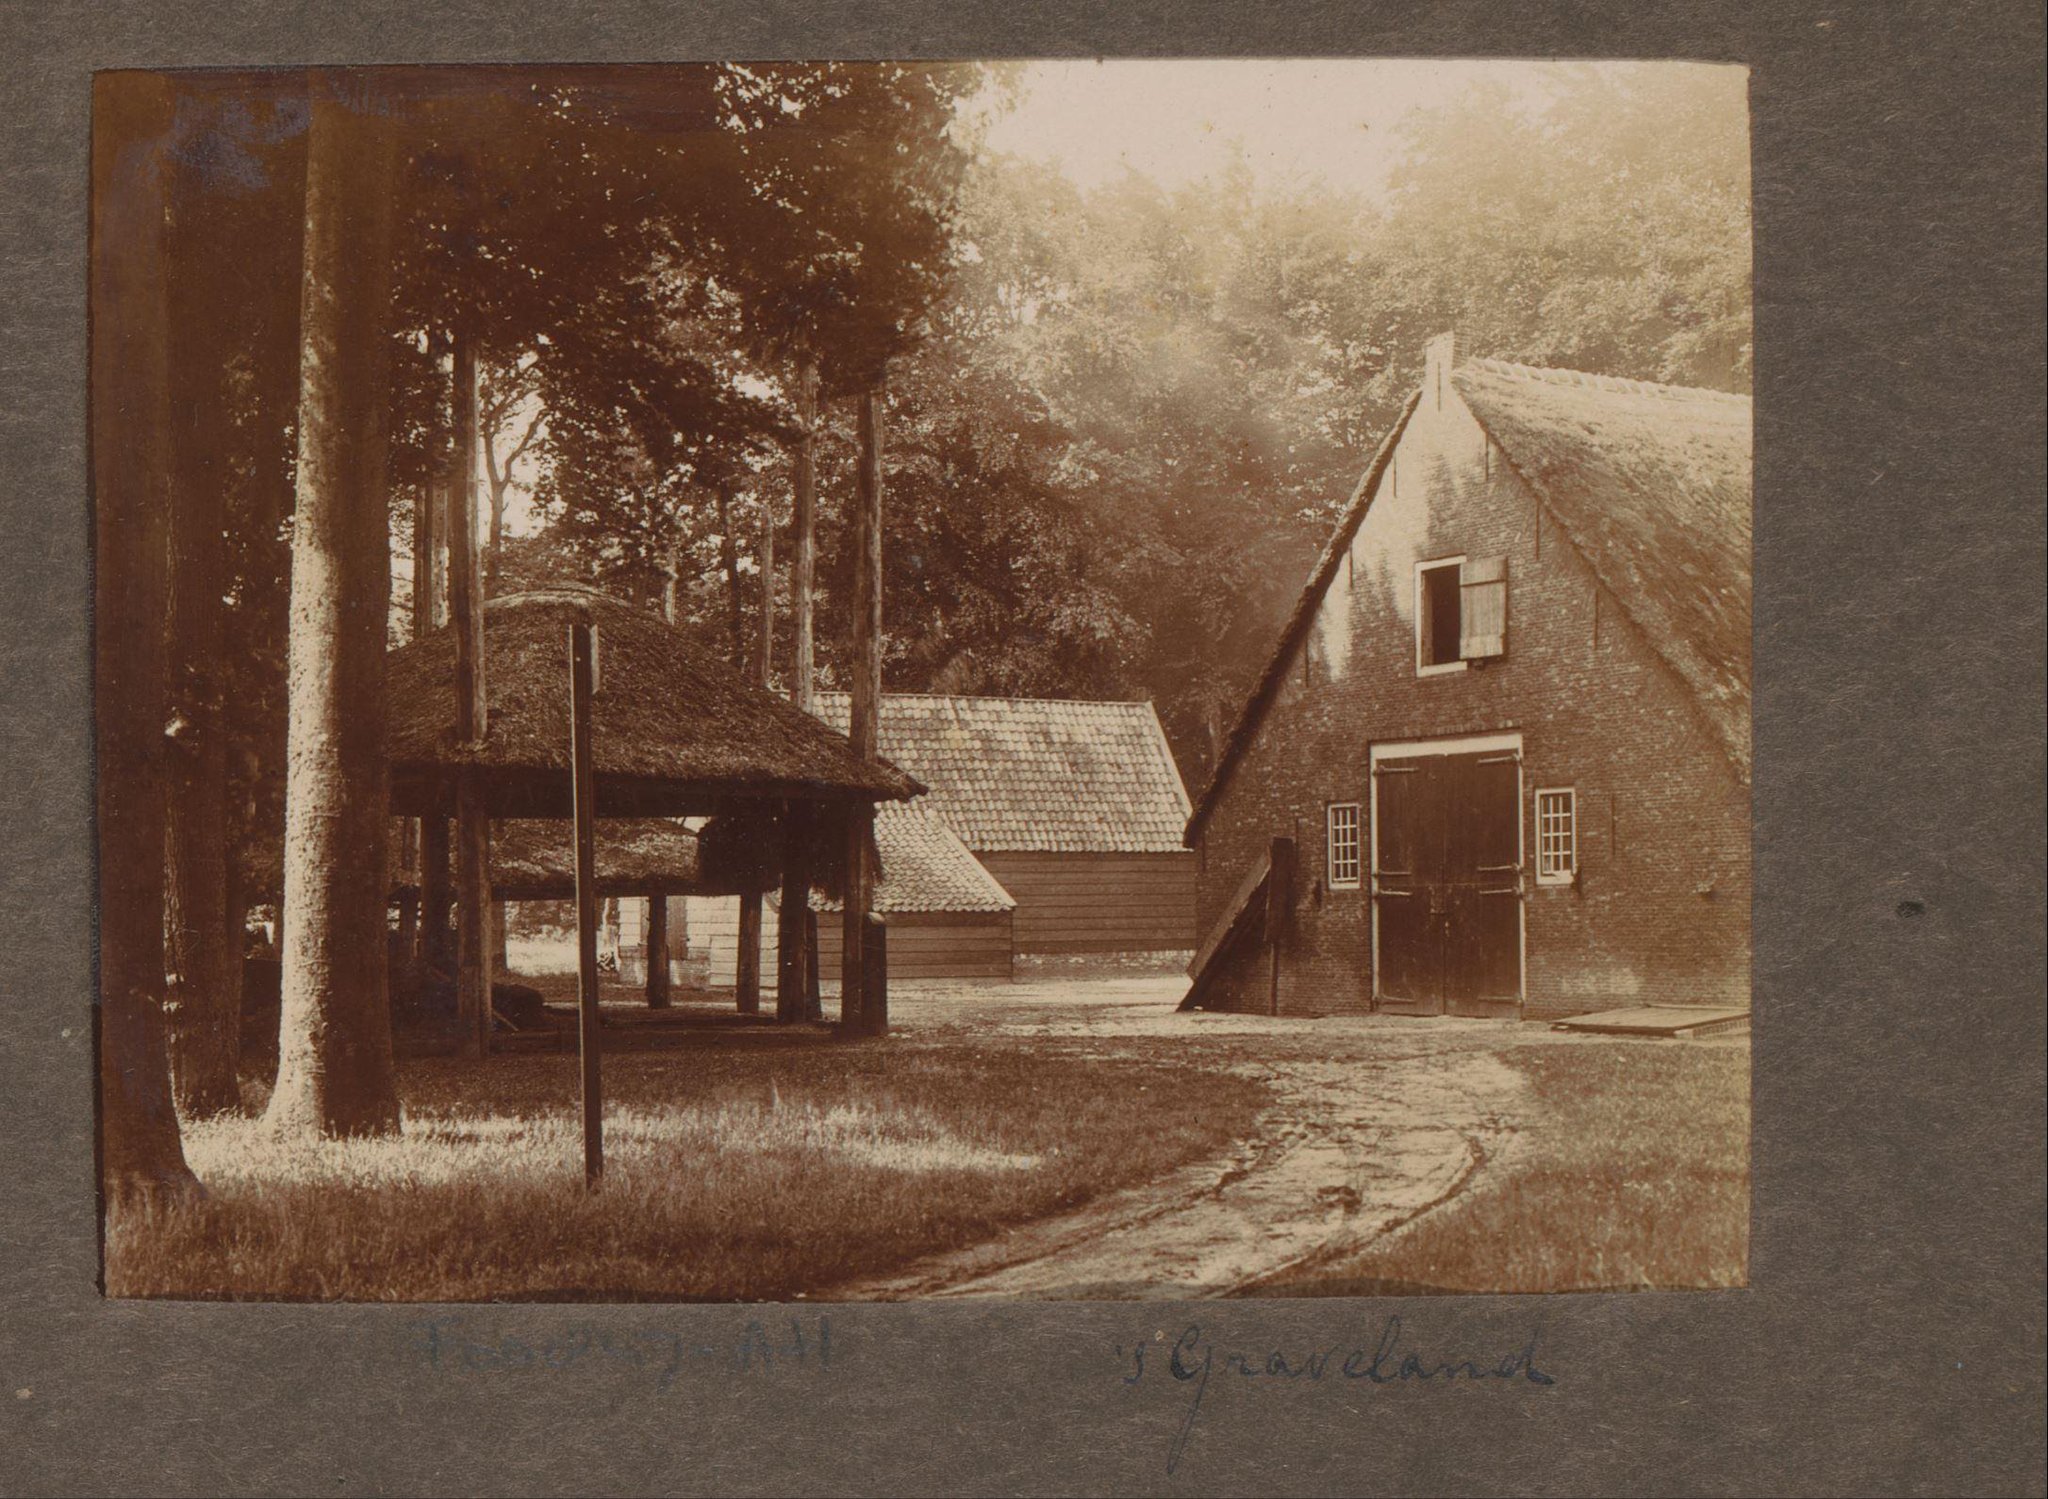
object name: album leaf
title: Boerderij met lege hooischuur in 's-Graveland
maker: Anonymous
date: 1902-1906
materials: cardboard, paper, photographic support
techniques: gelatin silver print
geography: s-graveland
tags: barn, farm (building)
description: Onderdeel van Reisalbum van een Nederlandse familie met bezienswaardigheden in Europa, Egypte en New York.